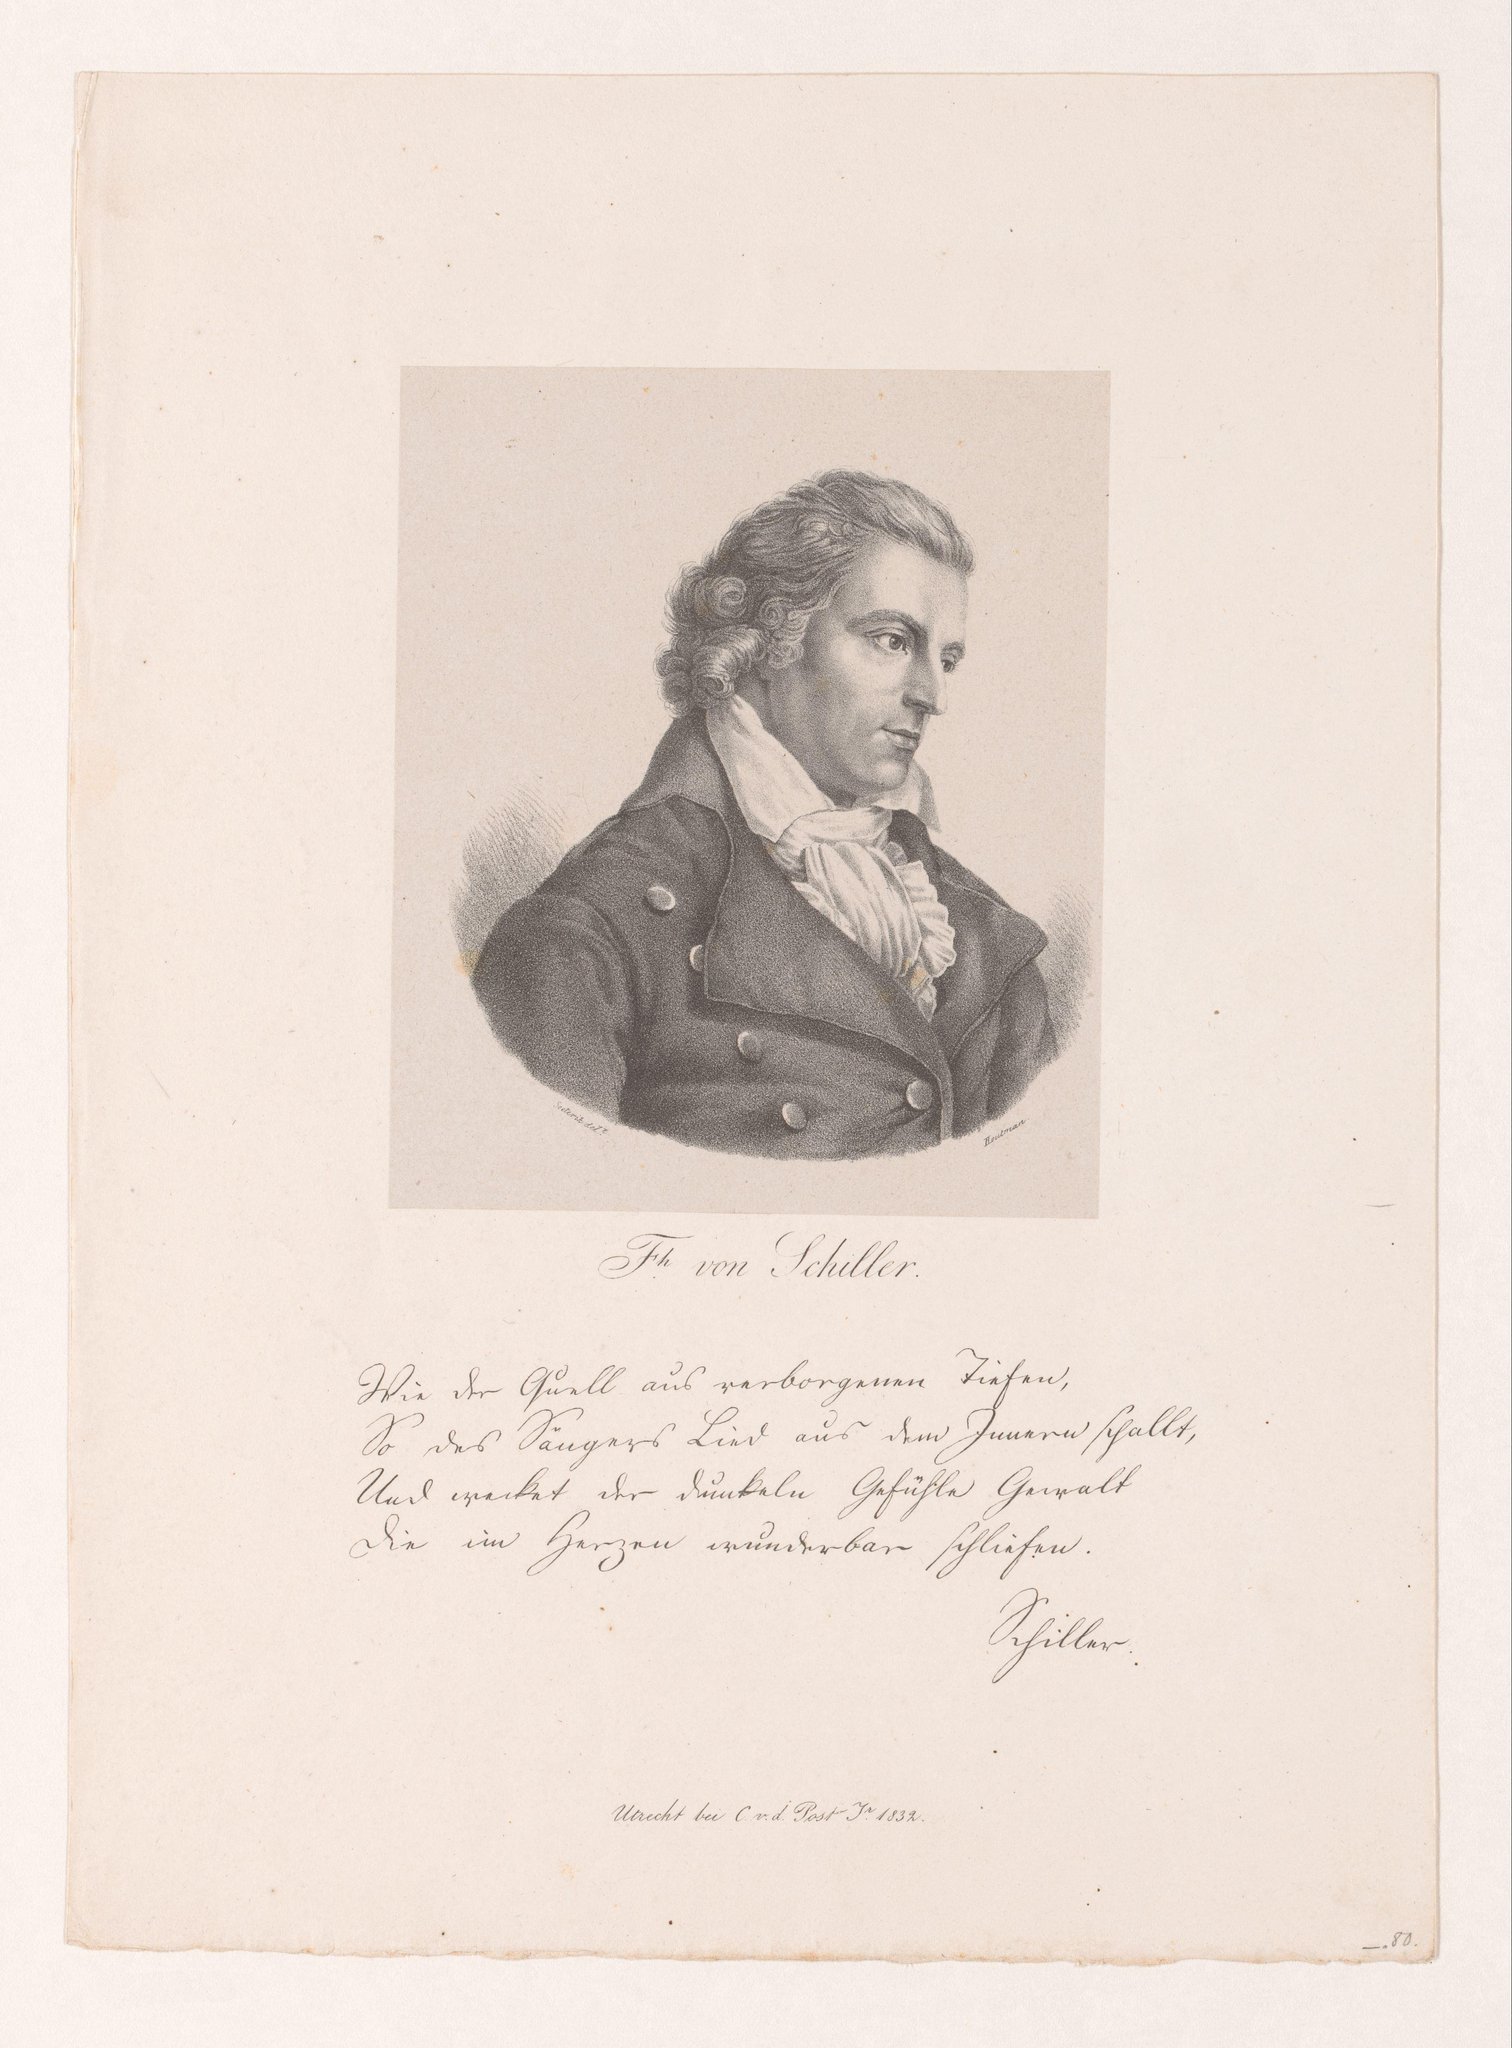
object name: print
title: Fr. von Schiller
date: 1832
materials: paper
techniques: lithograph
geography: utrecht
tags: friedrich von schiller, historical persons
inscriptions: collector's mark: Lugt 2228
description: Onder het portret een tekst en de signatuur van de geportretteerde.